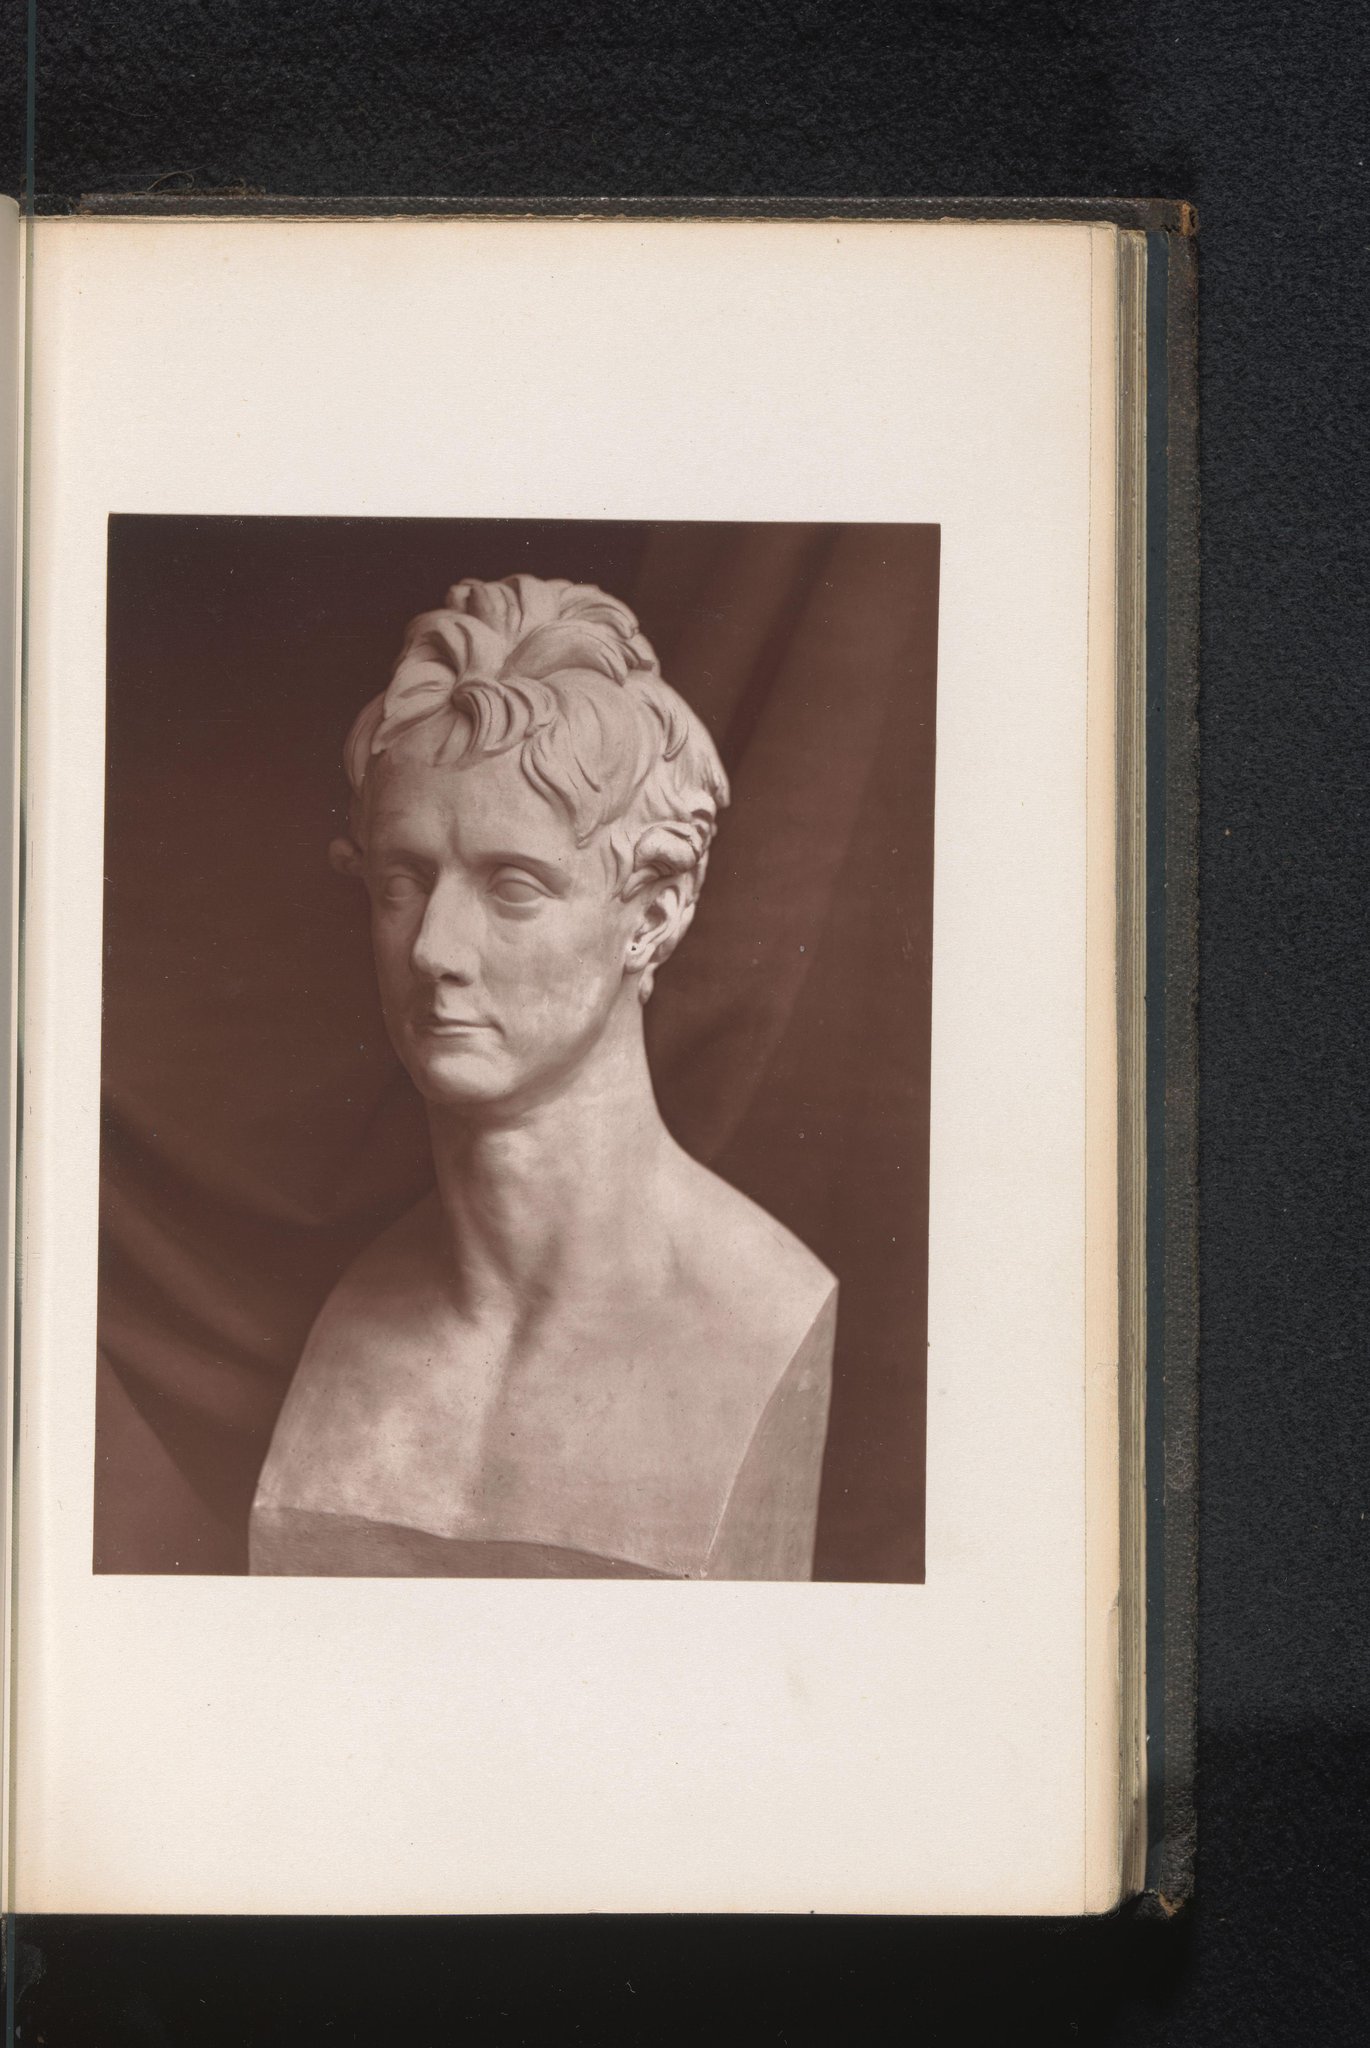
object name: page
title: Buste van Augustus William Hare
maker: Anonymous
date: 1866-1876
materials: paper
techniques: woodburytype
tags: chest, bust, sculpture